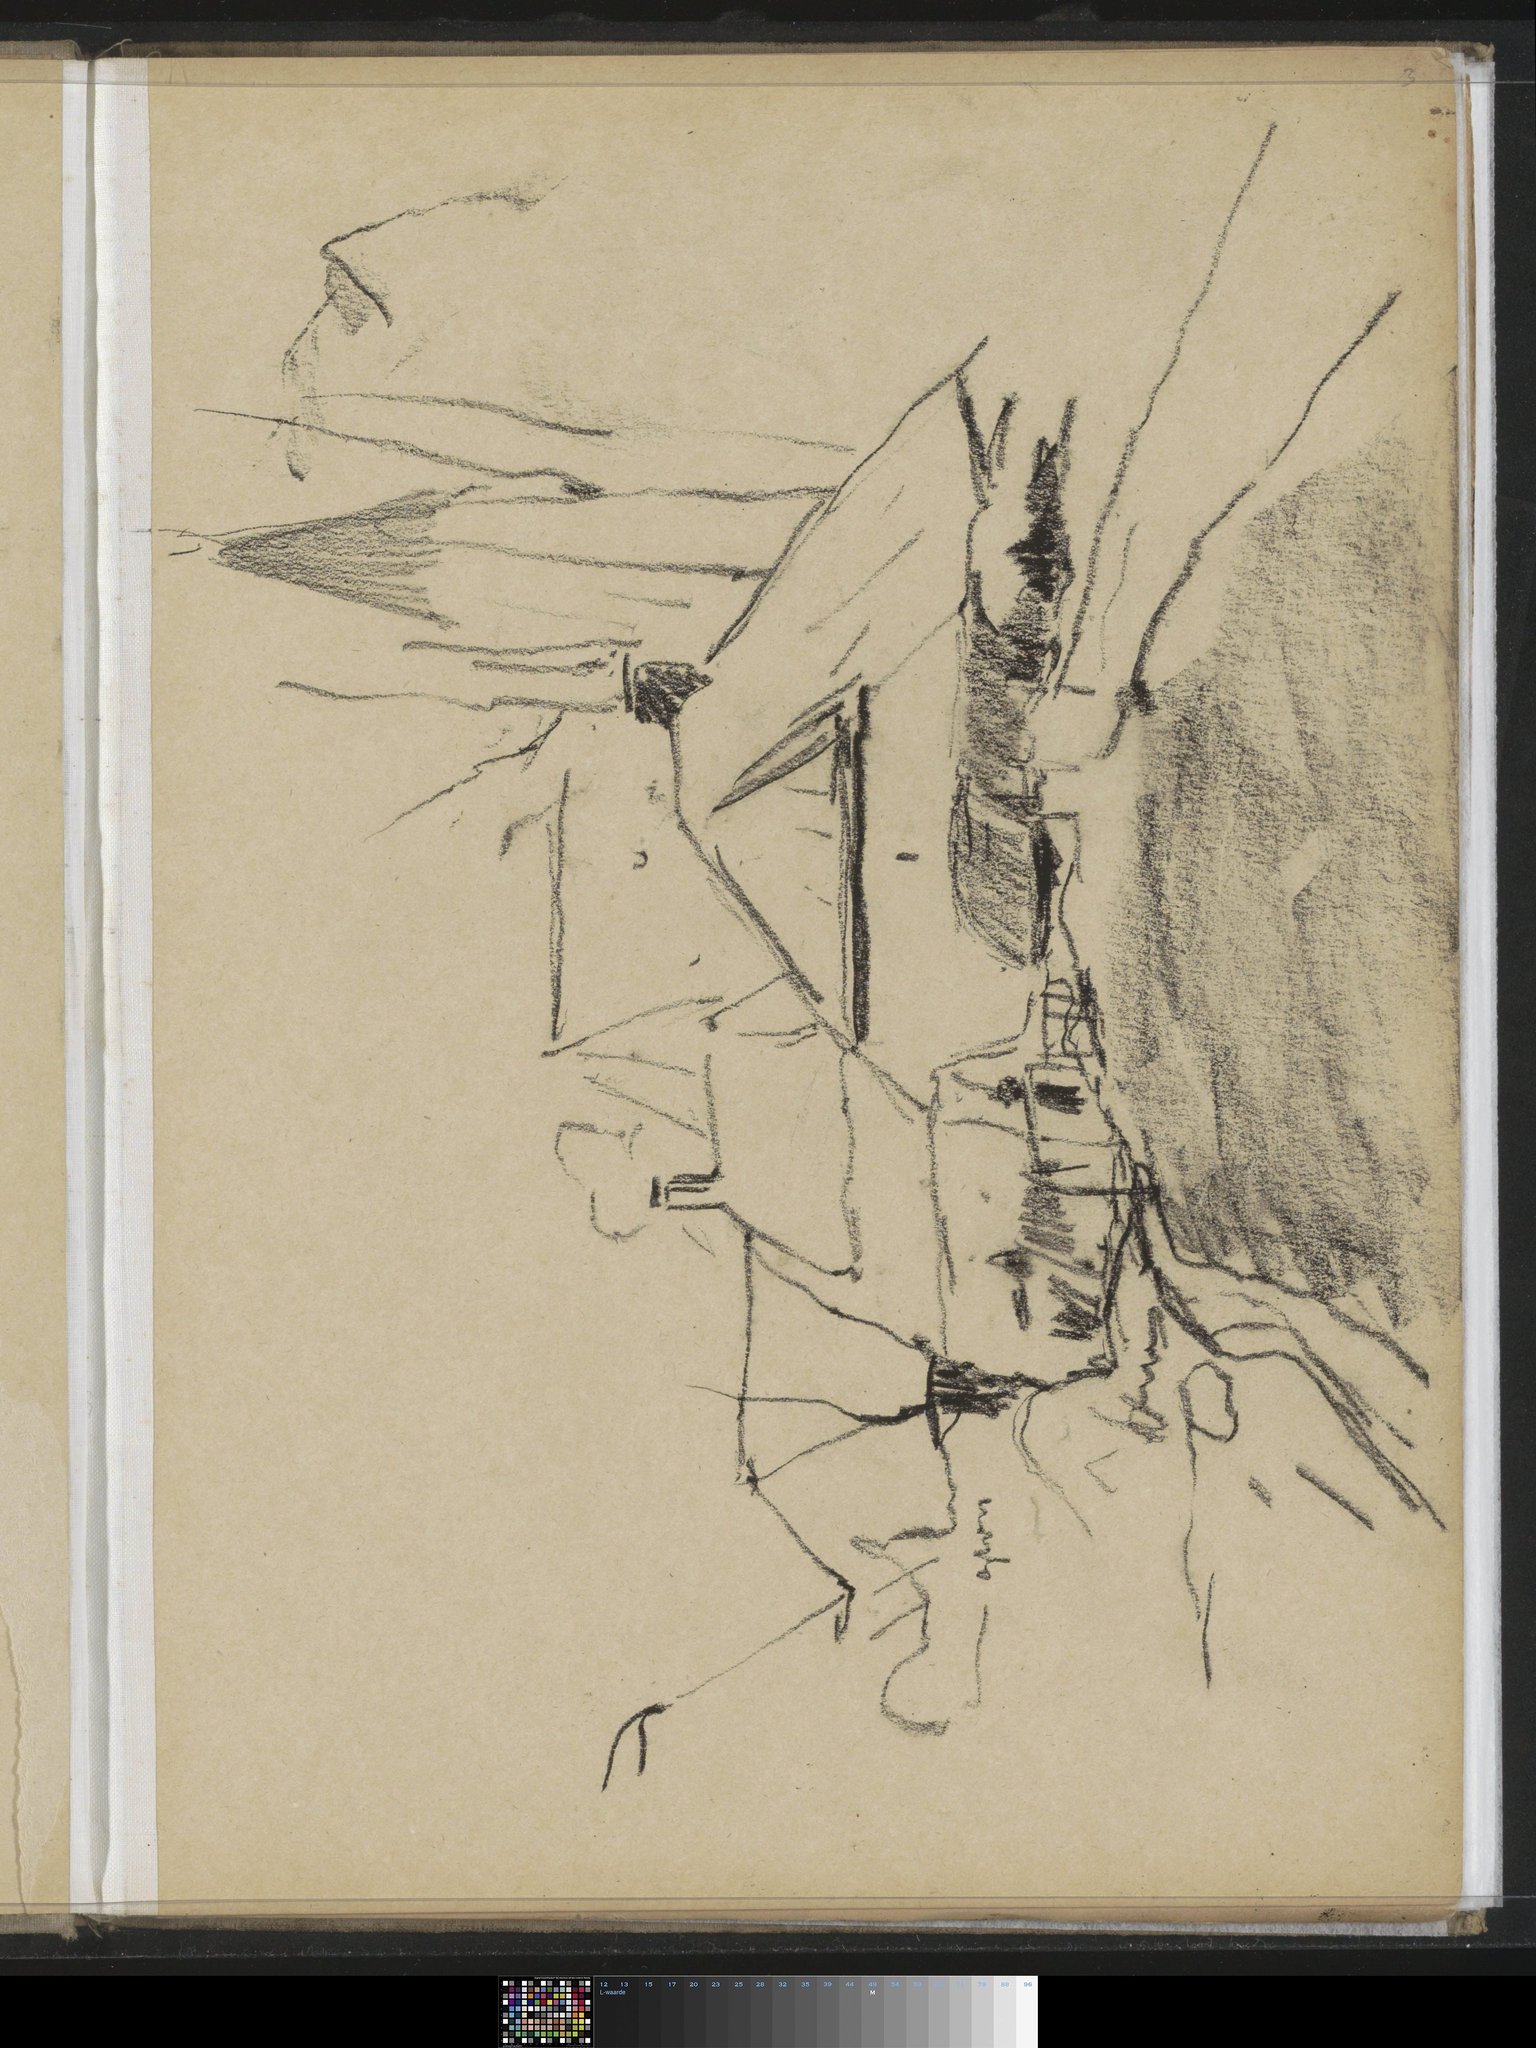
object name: sketchbook leaf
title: Boerderijen in Ede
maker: willem witsen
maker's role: draughtsman, painter, print maker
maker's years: 1860-1923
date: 1893-1897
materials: chalk, paper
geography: ede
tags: landscapes in the temperate zone, snow, farm (building)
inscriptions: kleurnotitie, handgeschreven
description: Voorstudie voor de ets 'Winteravond, Ede', ca. 1897.